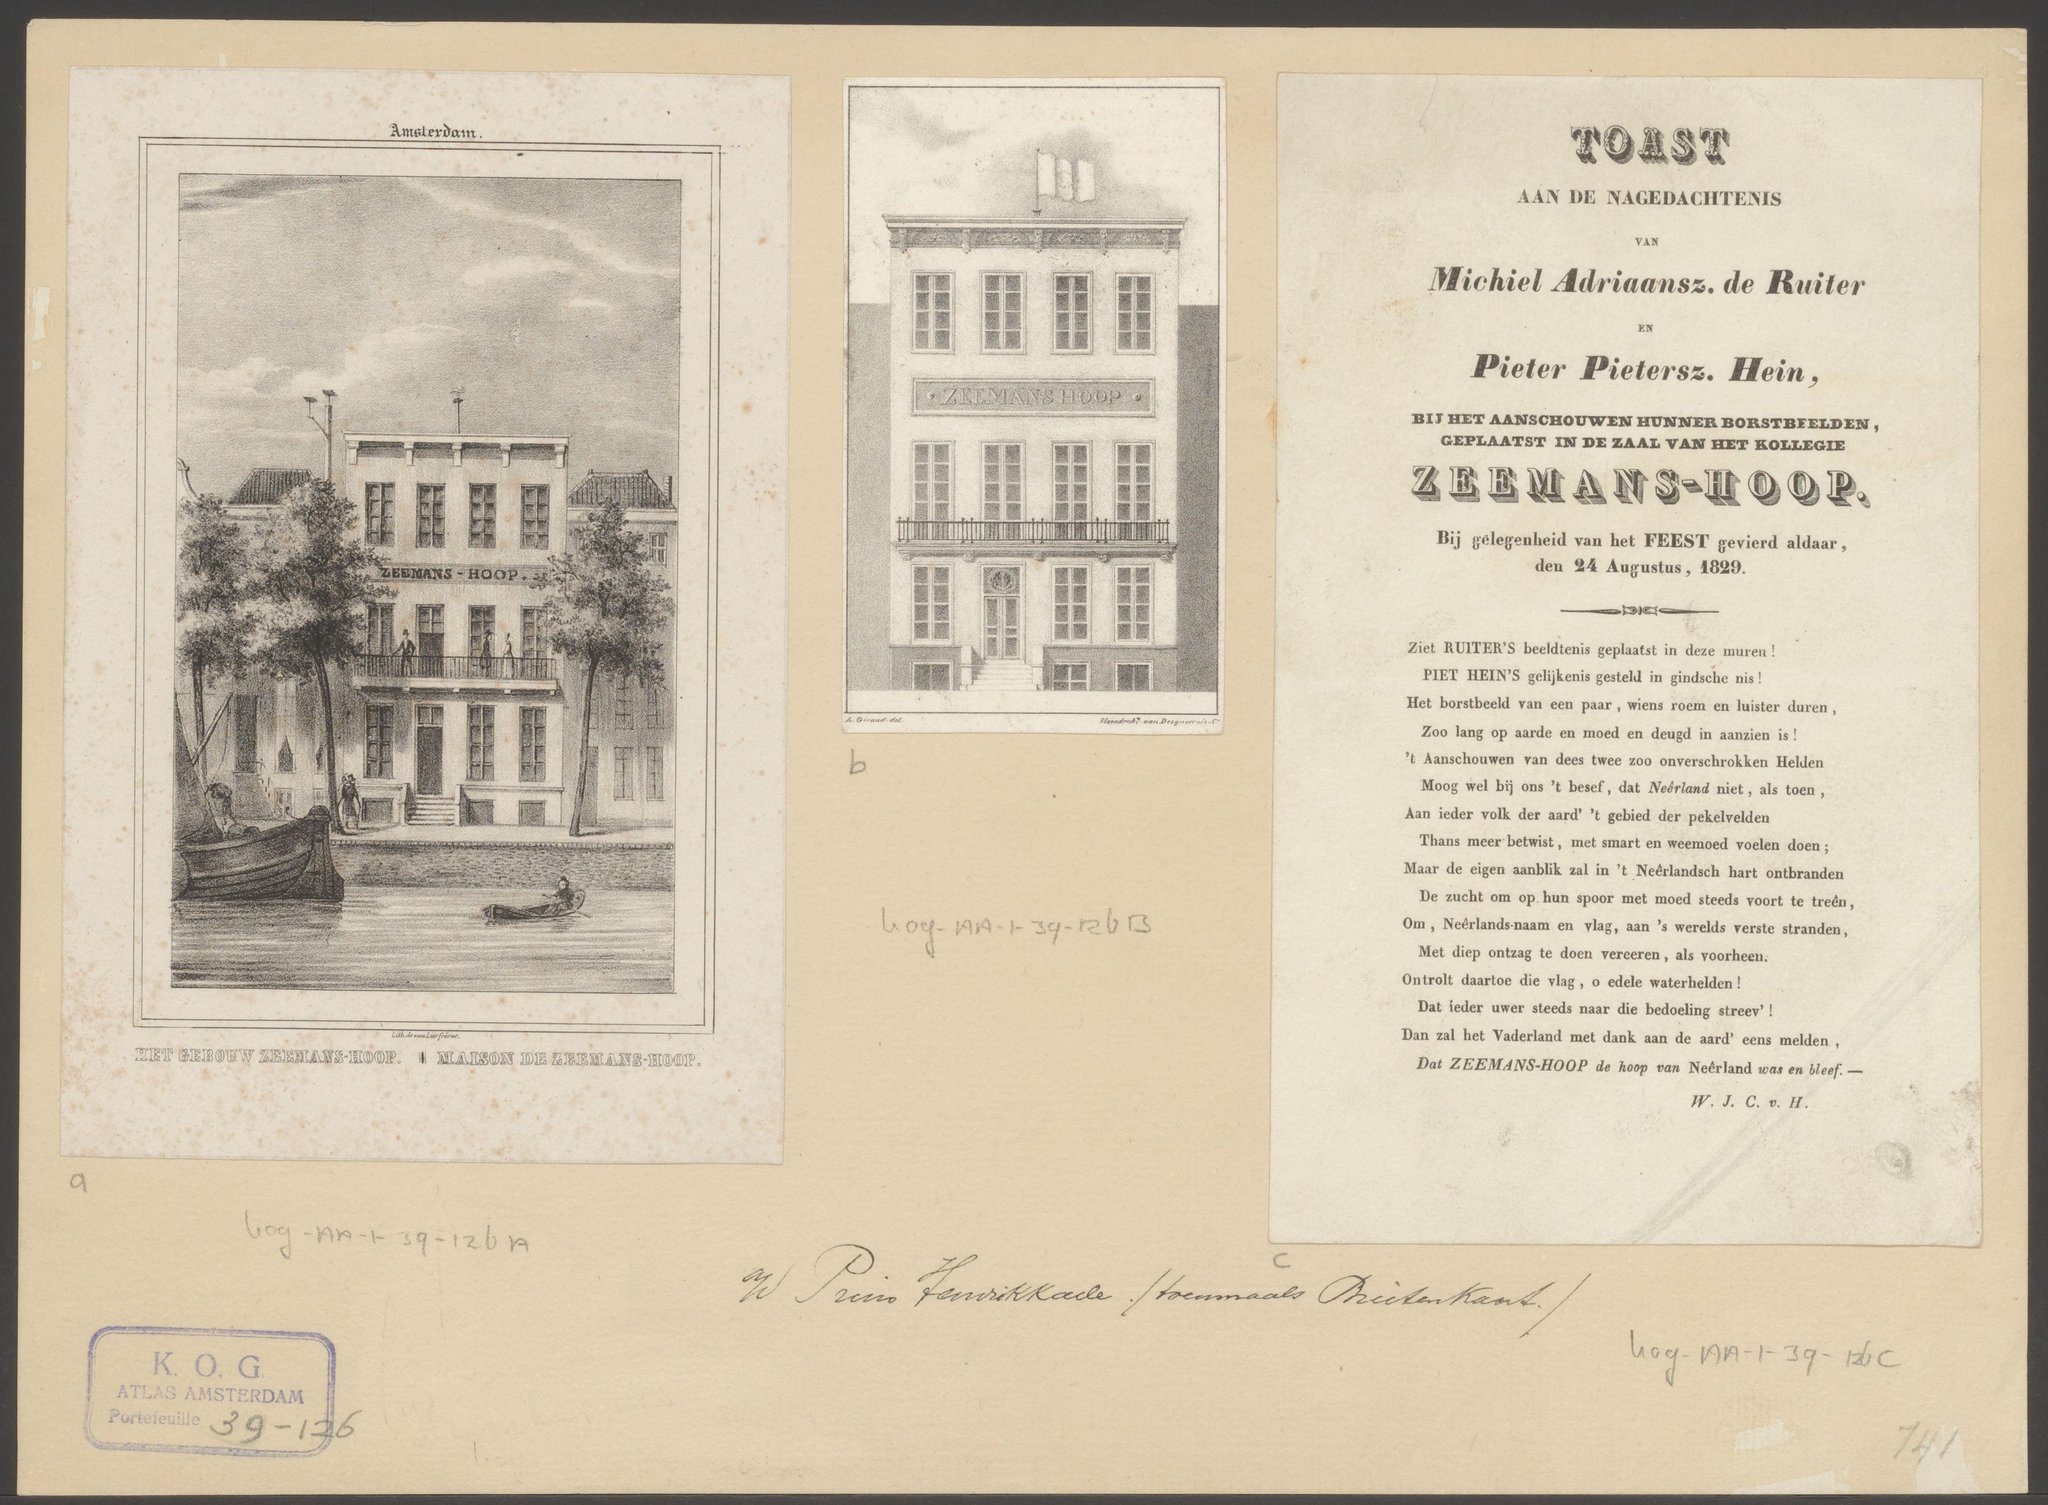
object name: print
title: Gezicht op het College Zeemanshoop aan de Prins Hendrikkade te Amsterdam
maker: alphonse pierre giraud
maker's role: print maker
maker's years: 1786-1863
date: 1828-1863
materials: paper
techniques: lithograph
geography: amsterdam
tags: civic architecture; edifices; dwellings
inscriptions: collector's mark: Lugt 1641b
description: Onderwerpsrubriek binnen de Atlas Amsterdam: Armwezen en liefdadige instellingen: III. Verschillende gestichten en instellingen / Hofjes: Zeemanshoop.